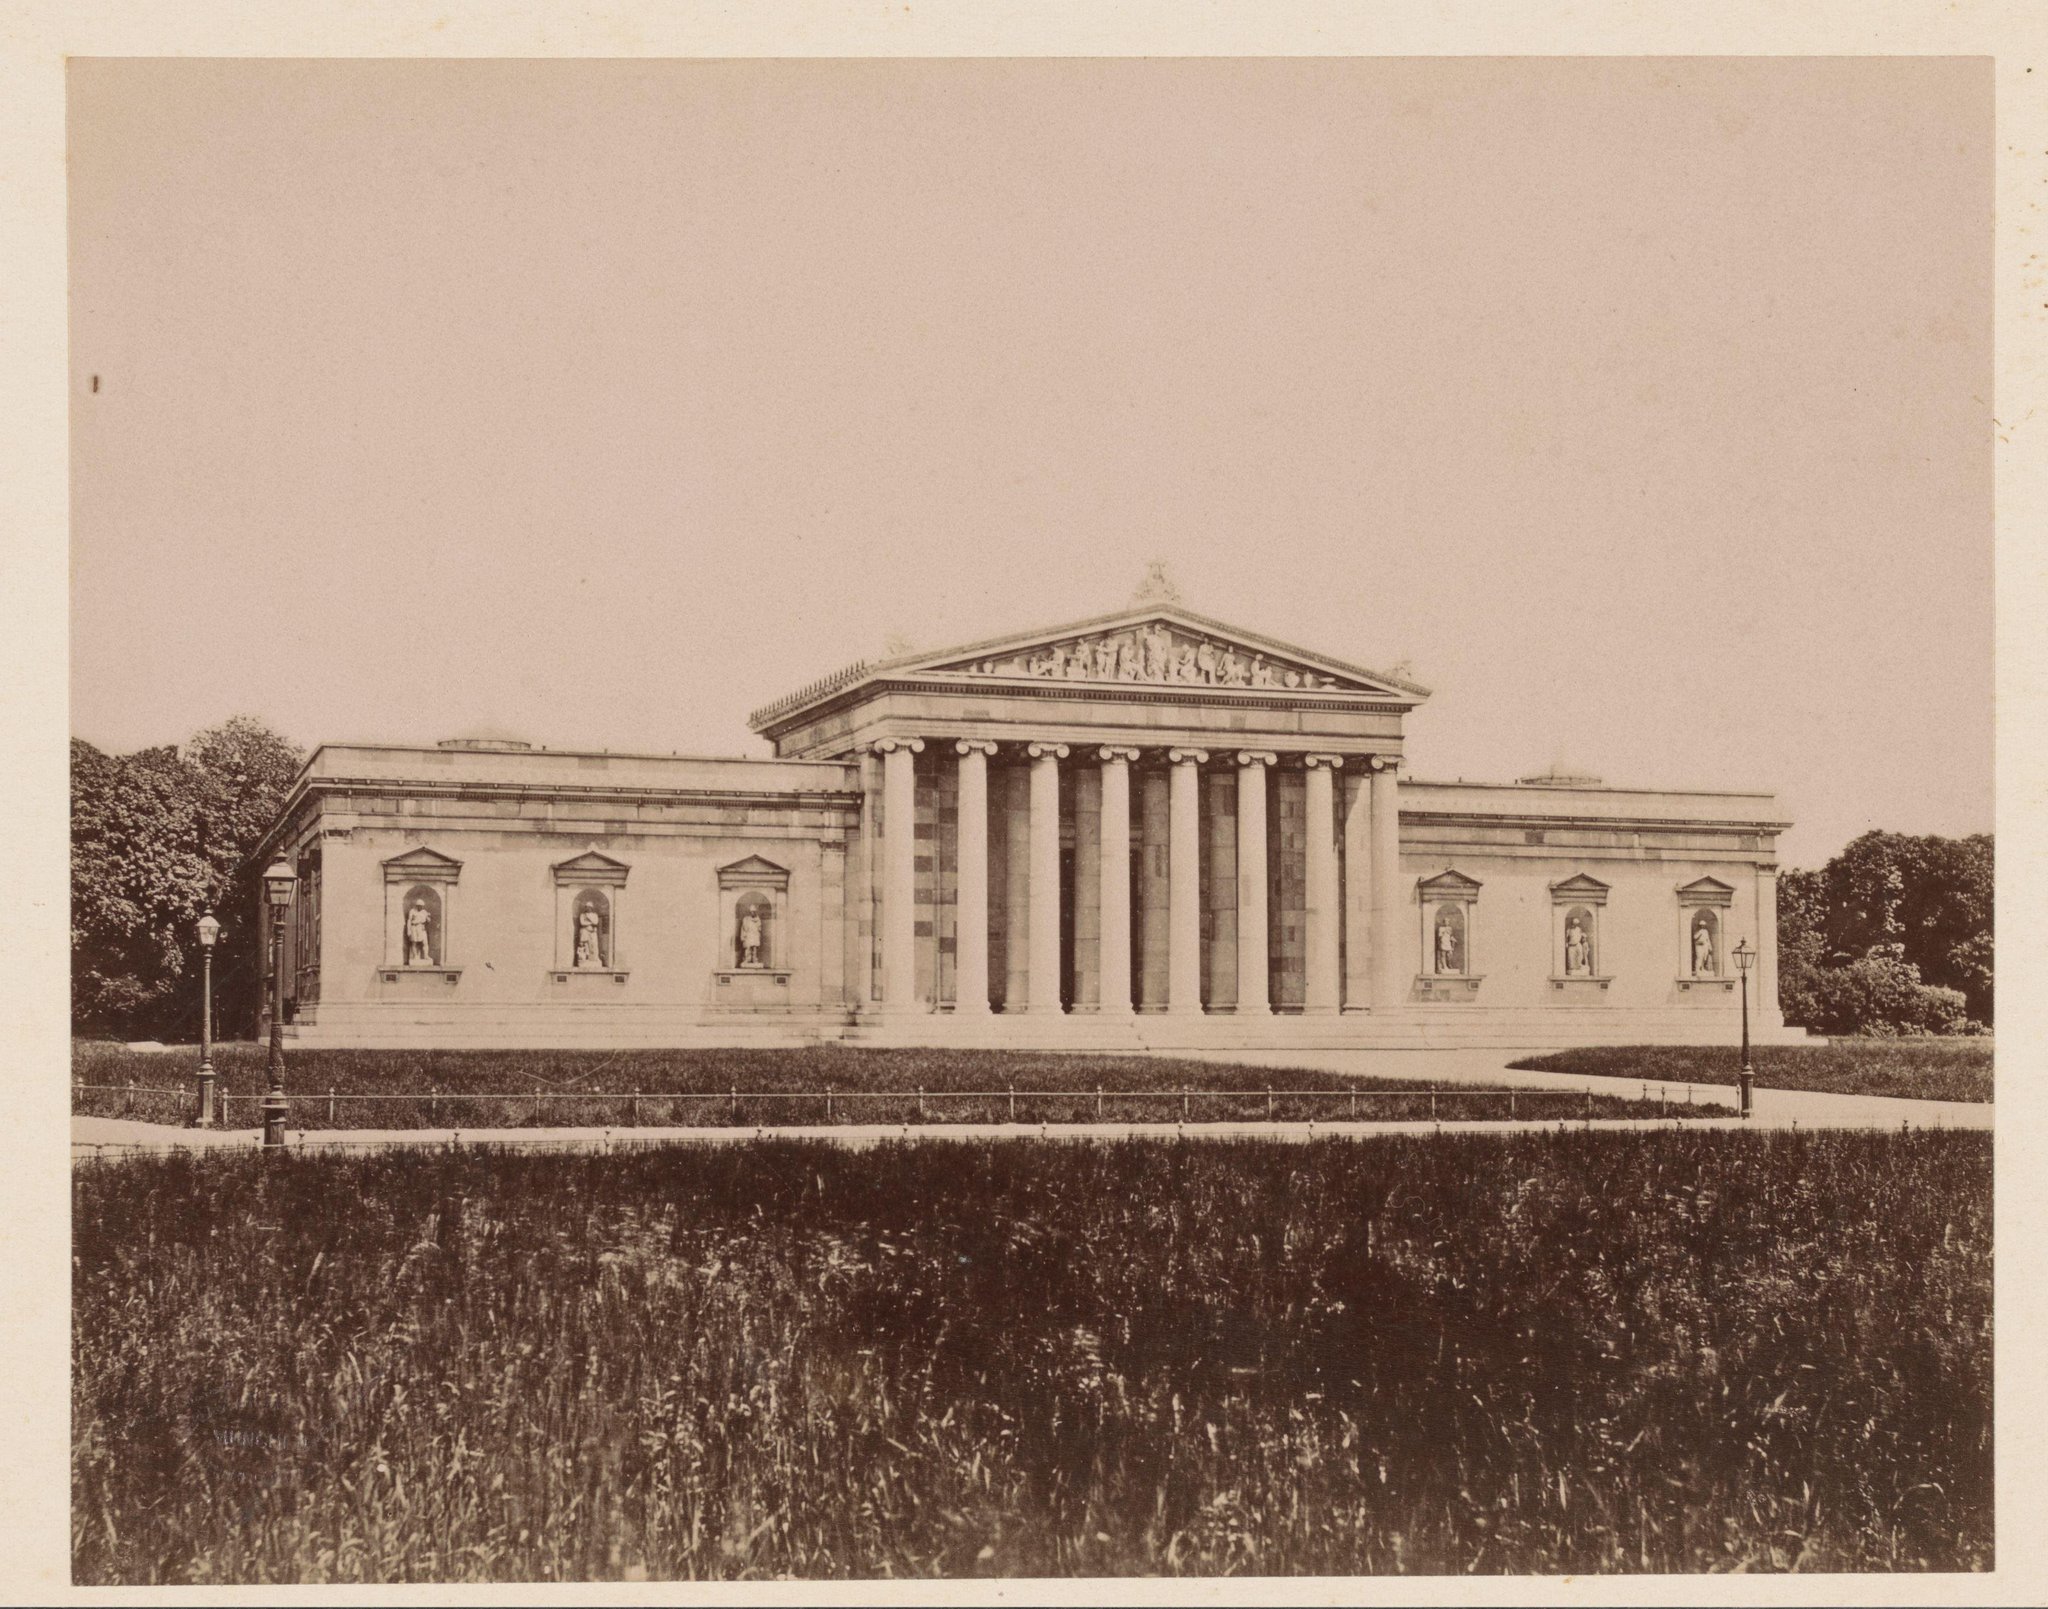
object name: photograph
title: Glyptothek in München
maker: Anonymous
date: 1863-1900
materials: cardboard, paper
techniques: albumen print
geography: munich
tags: permanent exhibition, museum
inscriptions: inscription: ‘München/ Glyptothek’, check stamp: ‘Verlagsanstalt f.K.u.W/ München/ vorm. Bruckmann’